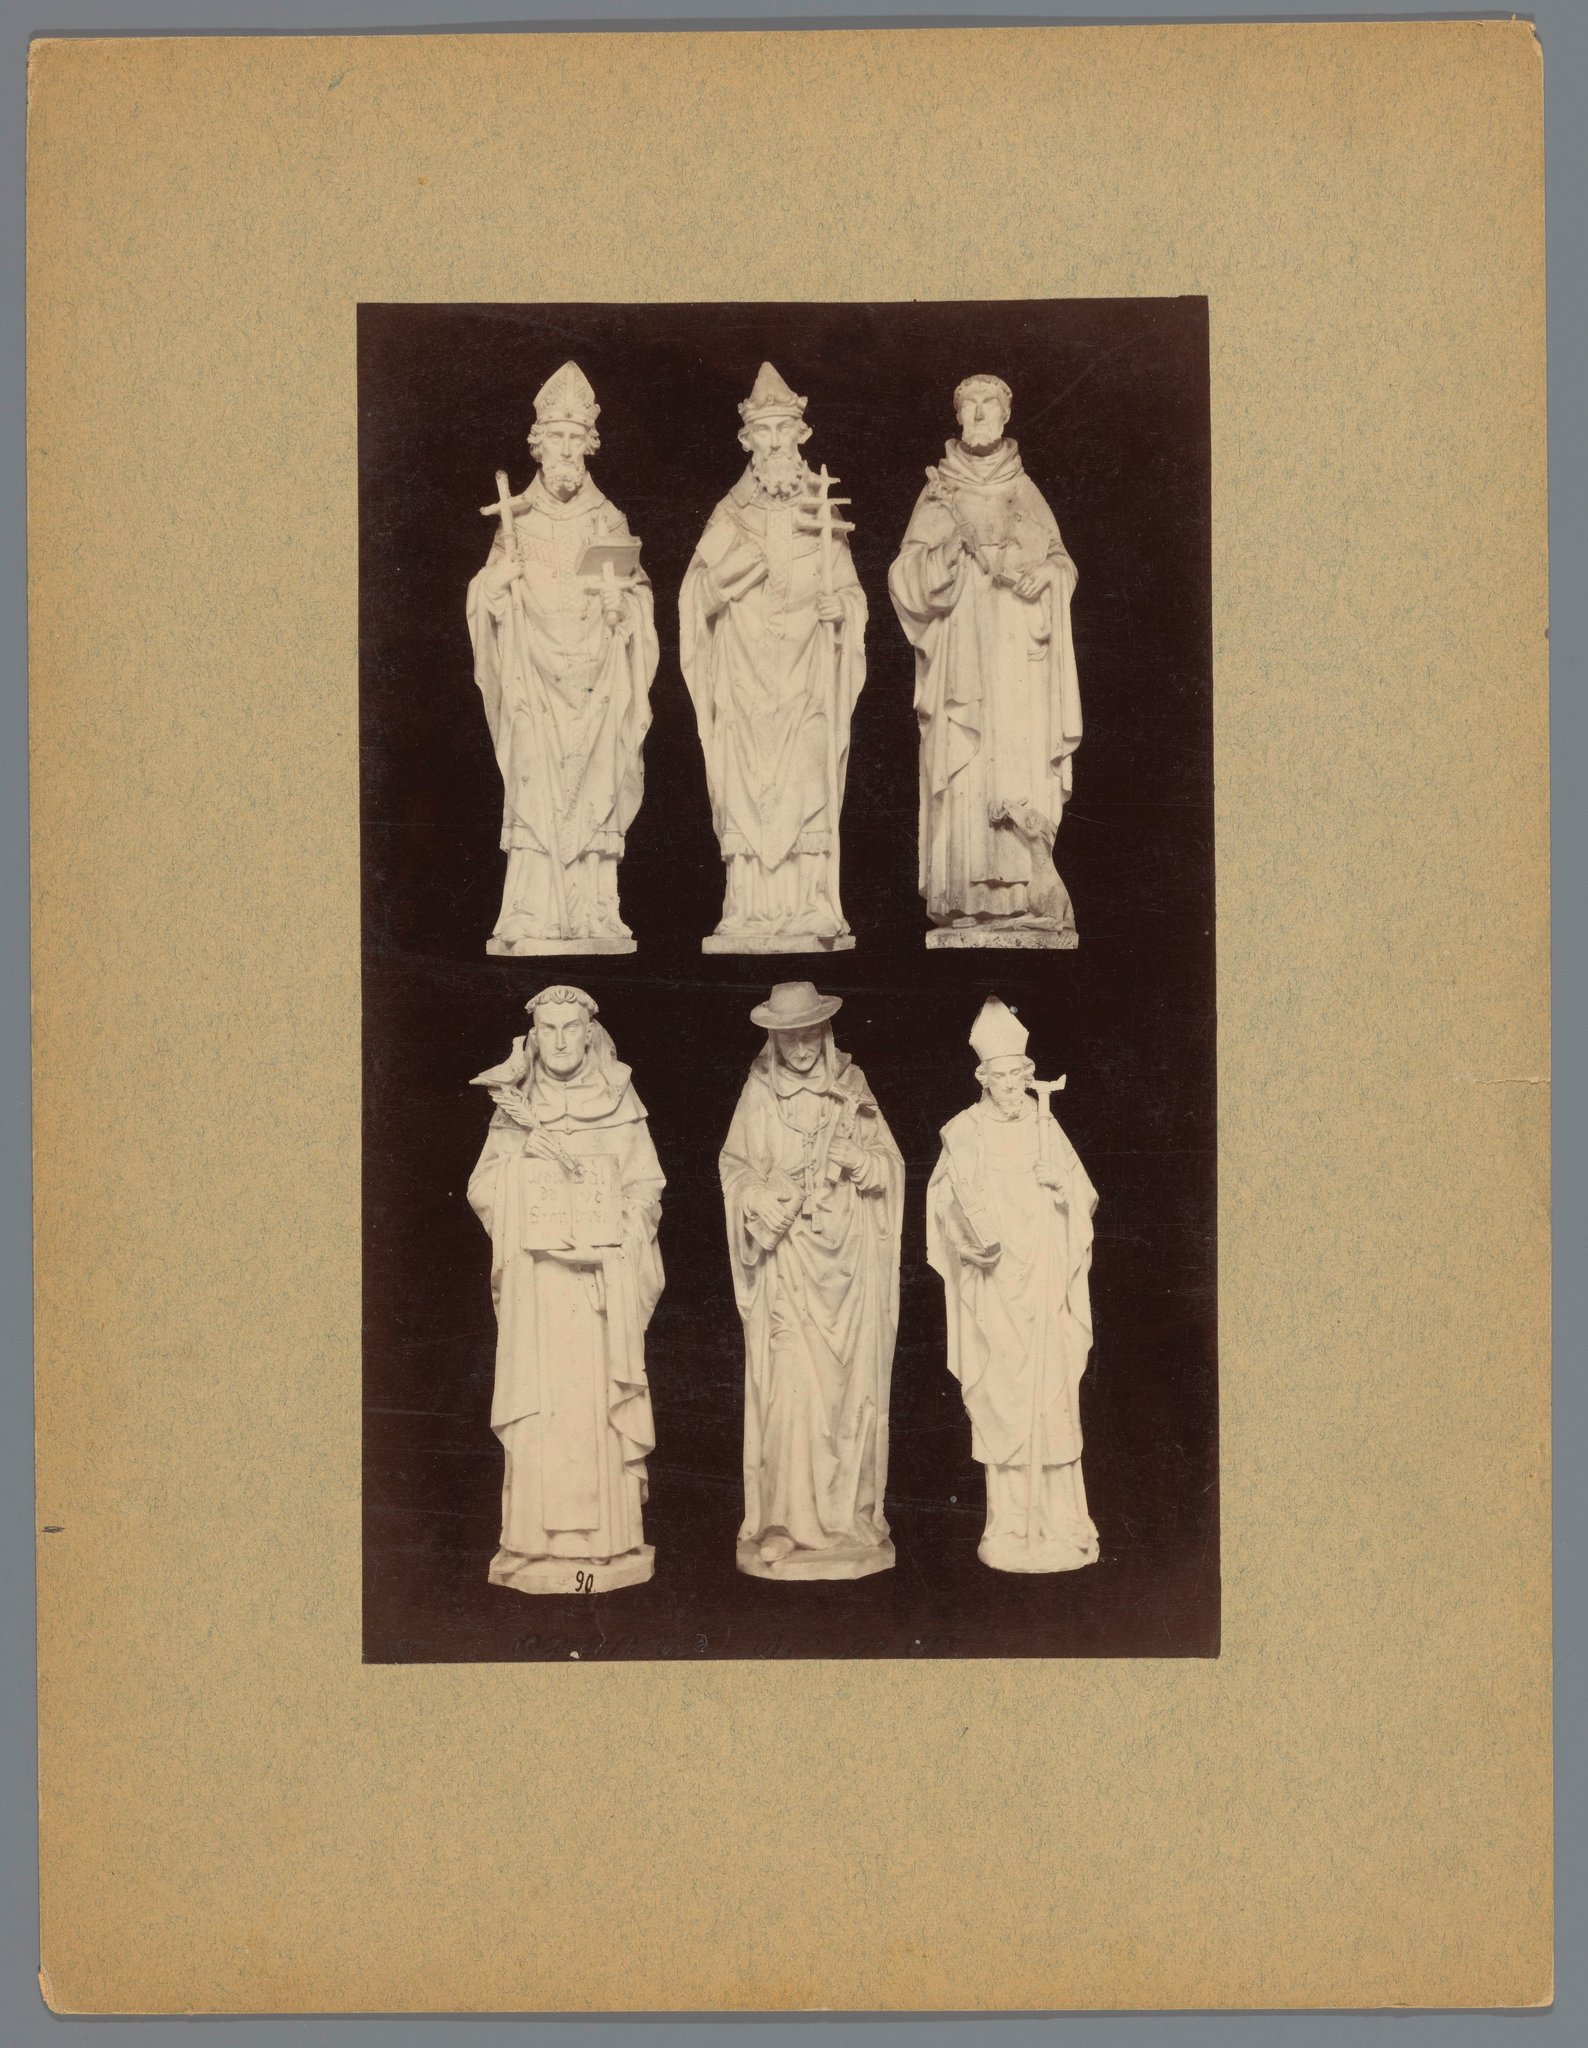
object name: photograph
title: Zes sculpturen van bisschoppen en geestelijken (vermoedelijk) van de Sint-Janskathedraal in 's-Hertogenbosch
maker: Anonymous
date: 1875-1900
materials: cardboard, photographic support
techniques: albumen print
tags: archbishop, bishop, etc. (roman catholic), insignia of bishop, e.g. mitre, crozier, book, sculpture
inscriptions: collector's mark: Lugt 3937, inscription: ‘B.F.R. Rives N[...]’, name: ‘KUNSTBOEKHANDEL J. A. G. DE LEUR PHOTOGRAAF - UITGEVER Huigenspark, 40b. DEN HAAG.’